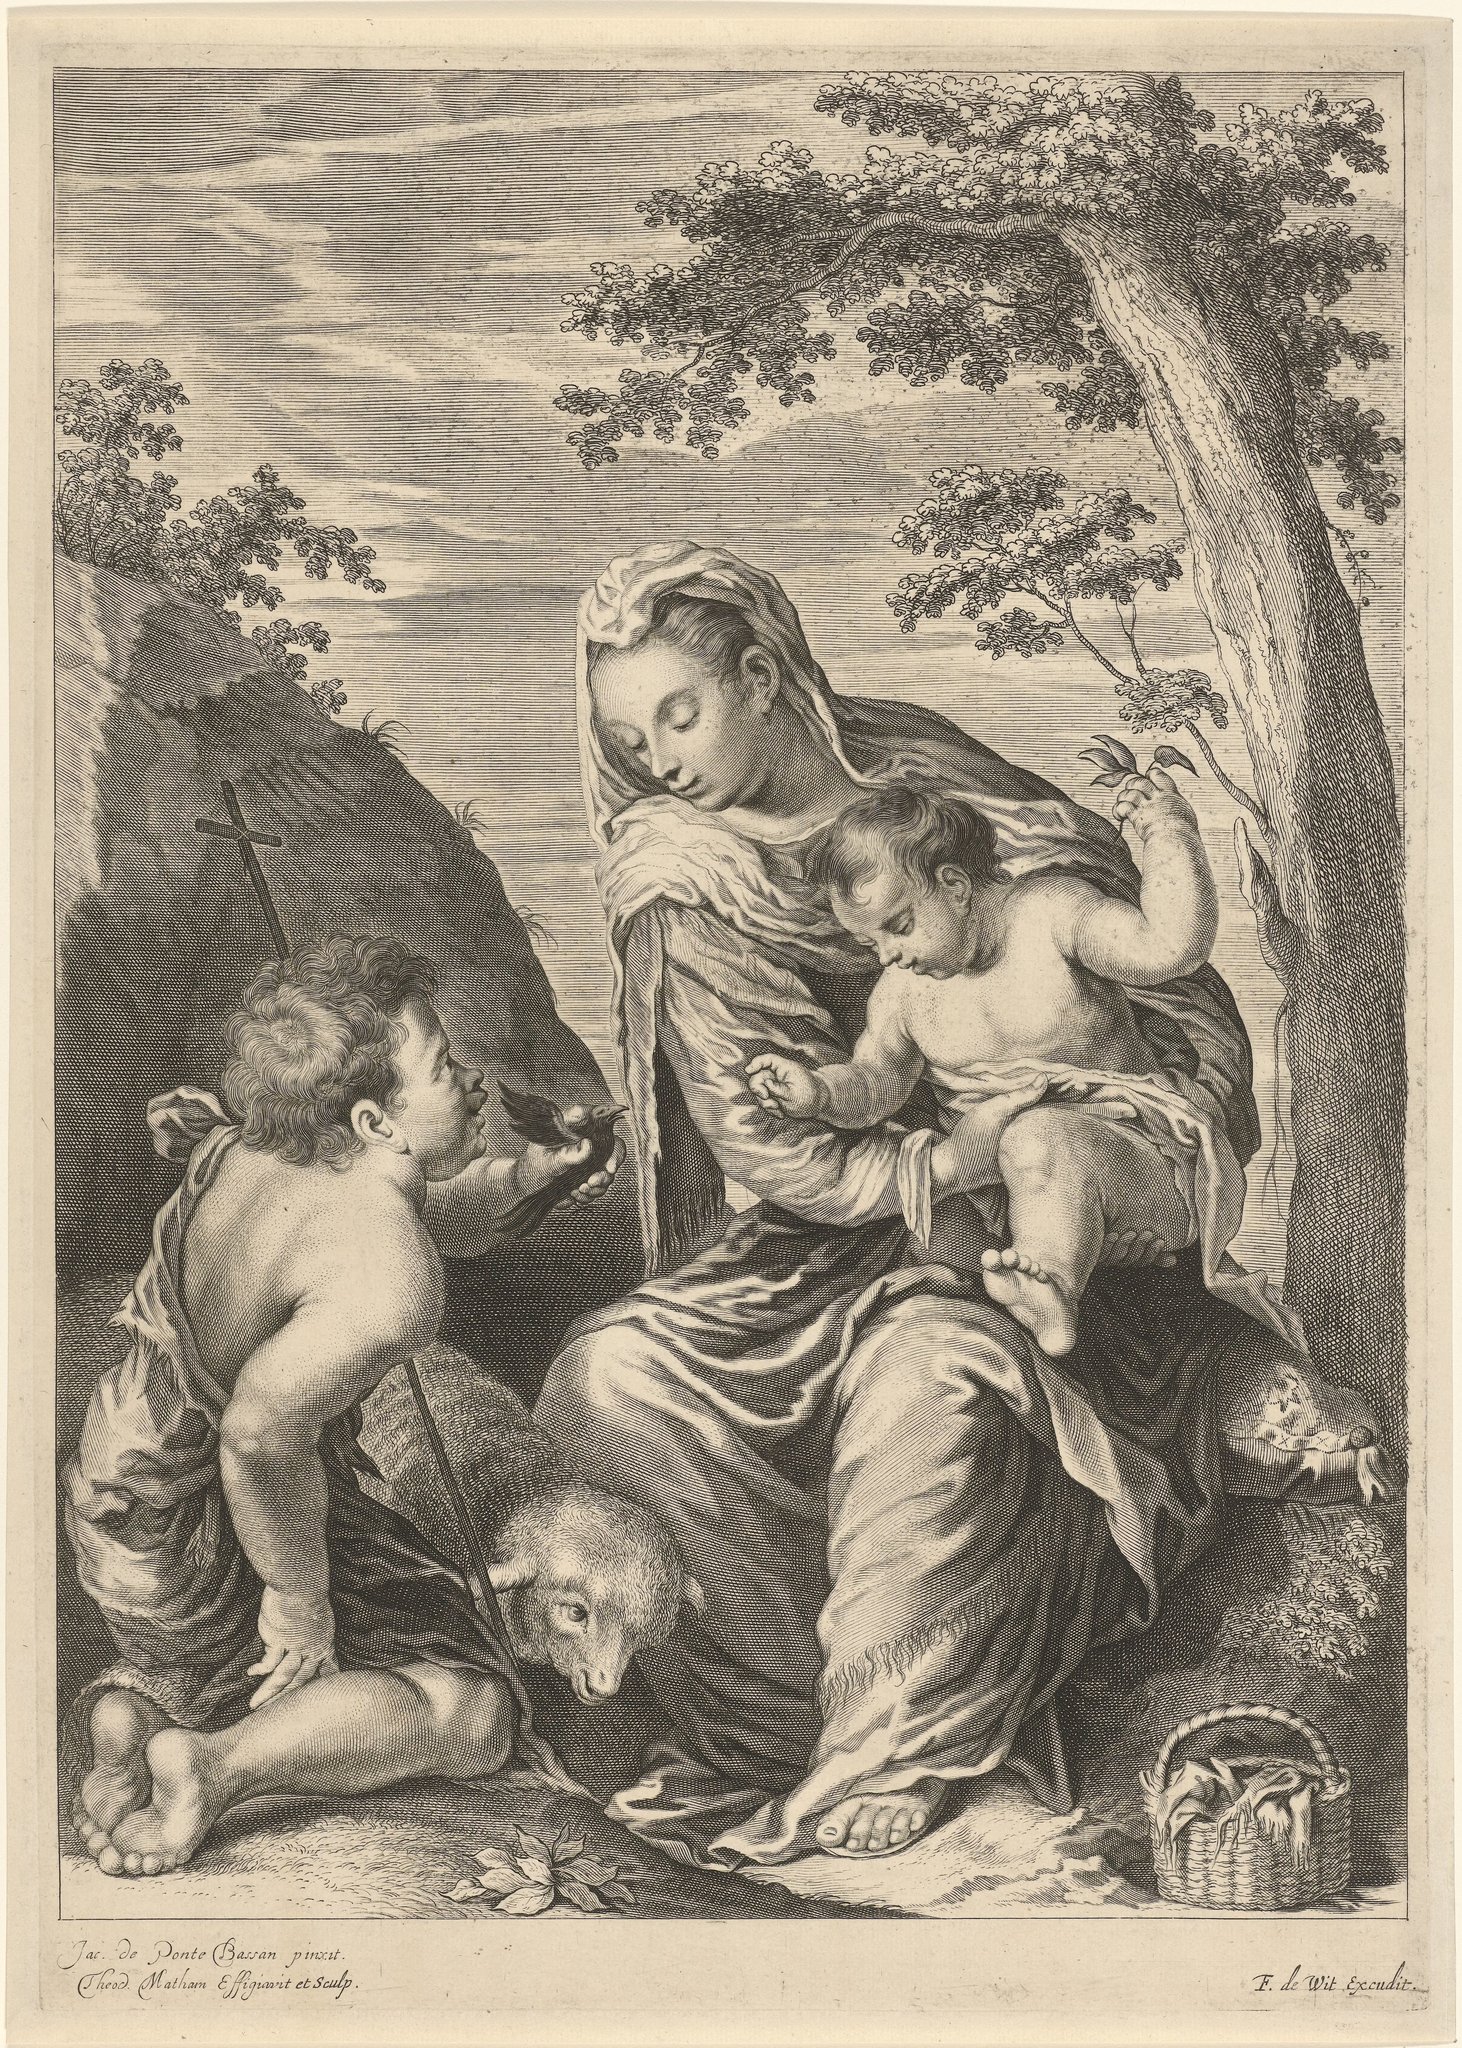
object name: print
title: Maria met Kind en Johannes de Doper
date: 1630-1690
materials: paper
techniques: engraving, etching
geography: amsterdam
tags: mary and the christ-child with john the baptist (as child)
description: Maria met Kind zittend bij een boom. Voor haar het kind Johannes dat het Christuskind een vogel aanbiedt.